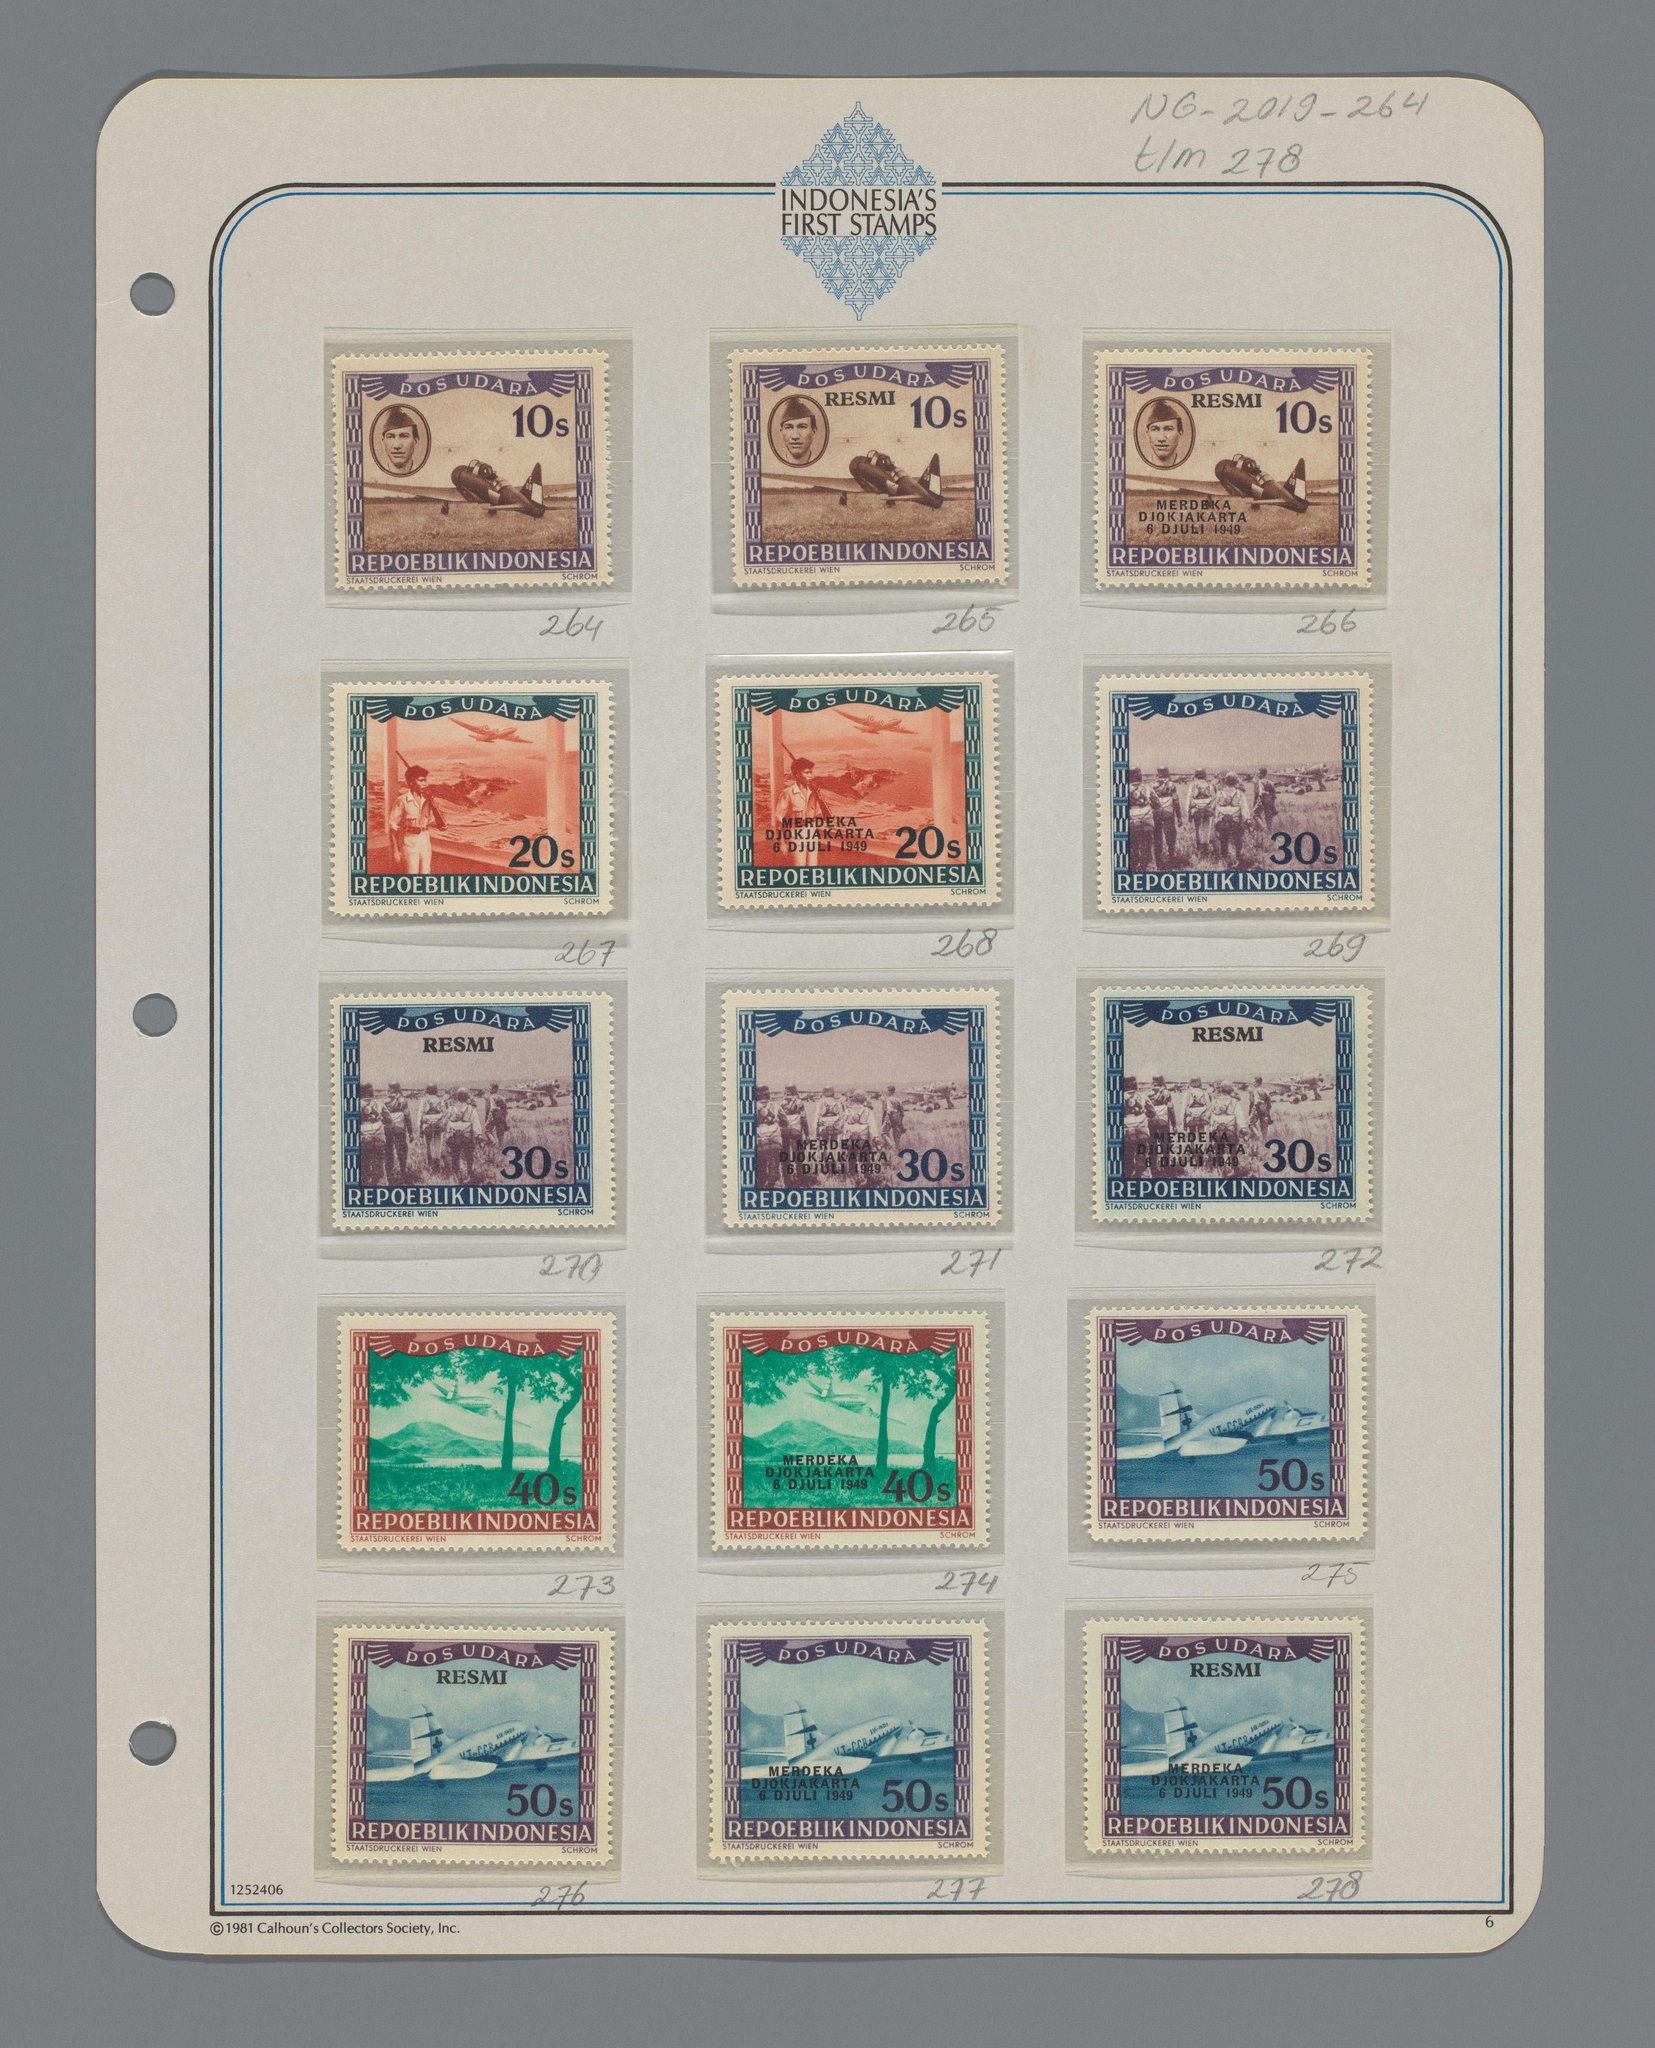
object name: postage stamp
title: Postzegel Republik Indonesia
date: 1949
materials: paper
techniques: photoaquatint, engraving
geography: vienna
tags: indonesia